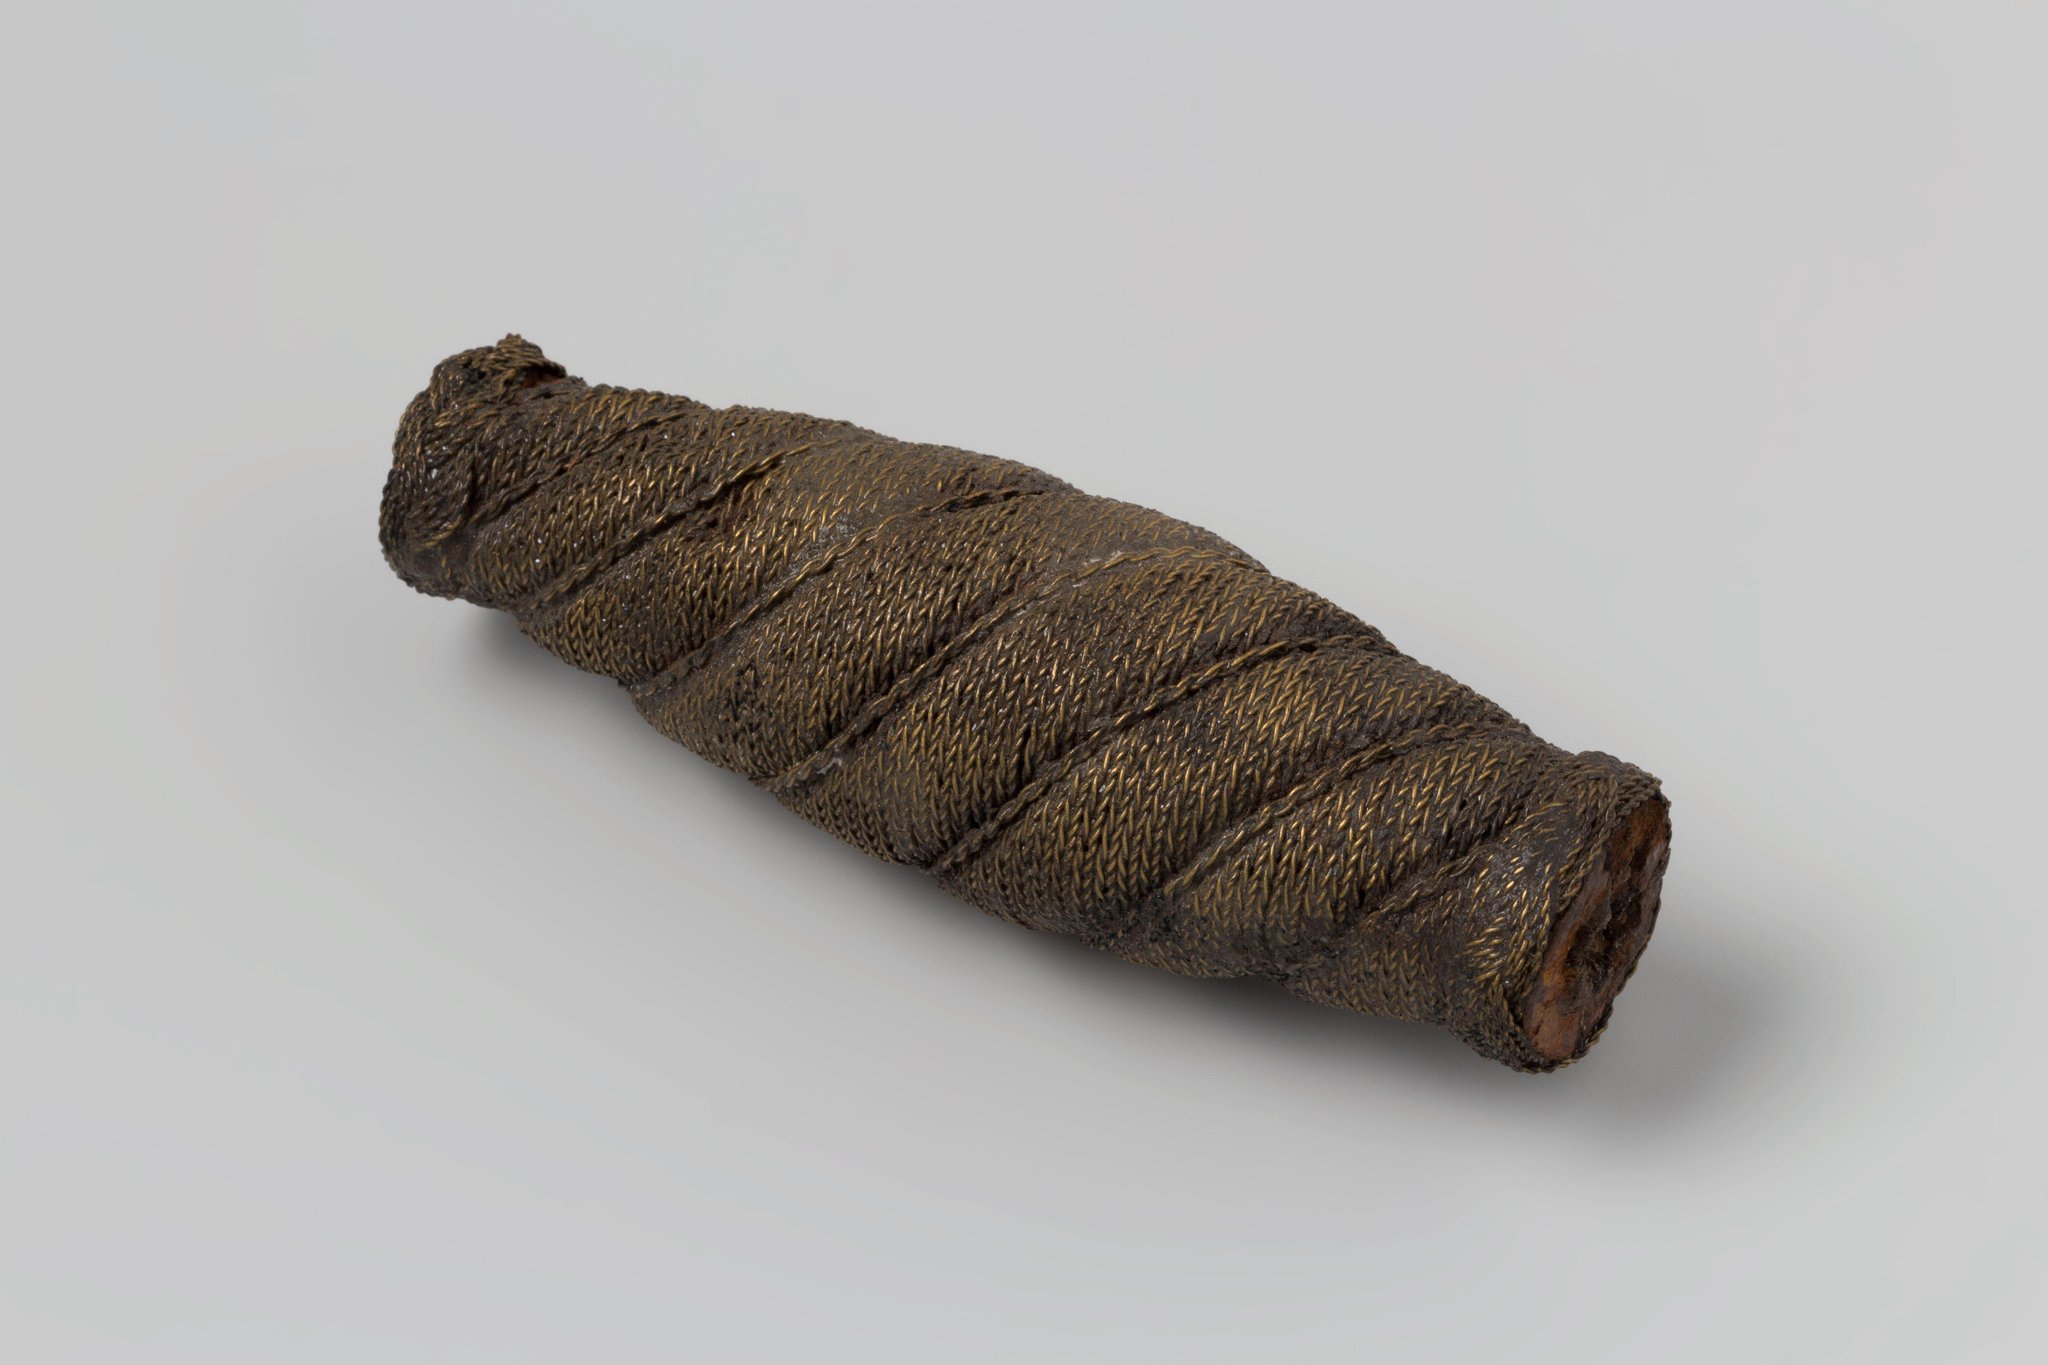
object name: greep gevest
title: Greep van gevest uit het wrak van de Oost-Indiëvaarder 't Vliegend Hart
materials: copper, wood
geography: middelburg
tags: 't vliegend hart (schip), verenigde oostindische compagnie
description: Greep van een gevest van een blank wapen bestaande uit een ronde houten kern verticaal dekkend omwonden door driestrengs koperdraad en één diagonale tweestrengs koperdraad. Van dit exemplaar glimt het koperdraad. De greep is rechthoekig uitgeboord.